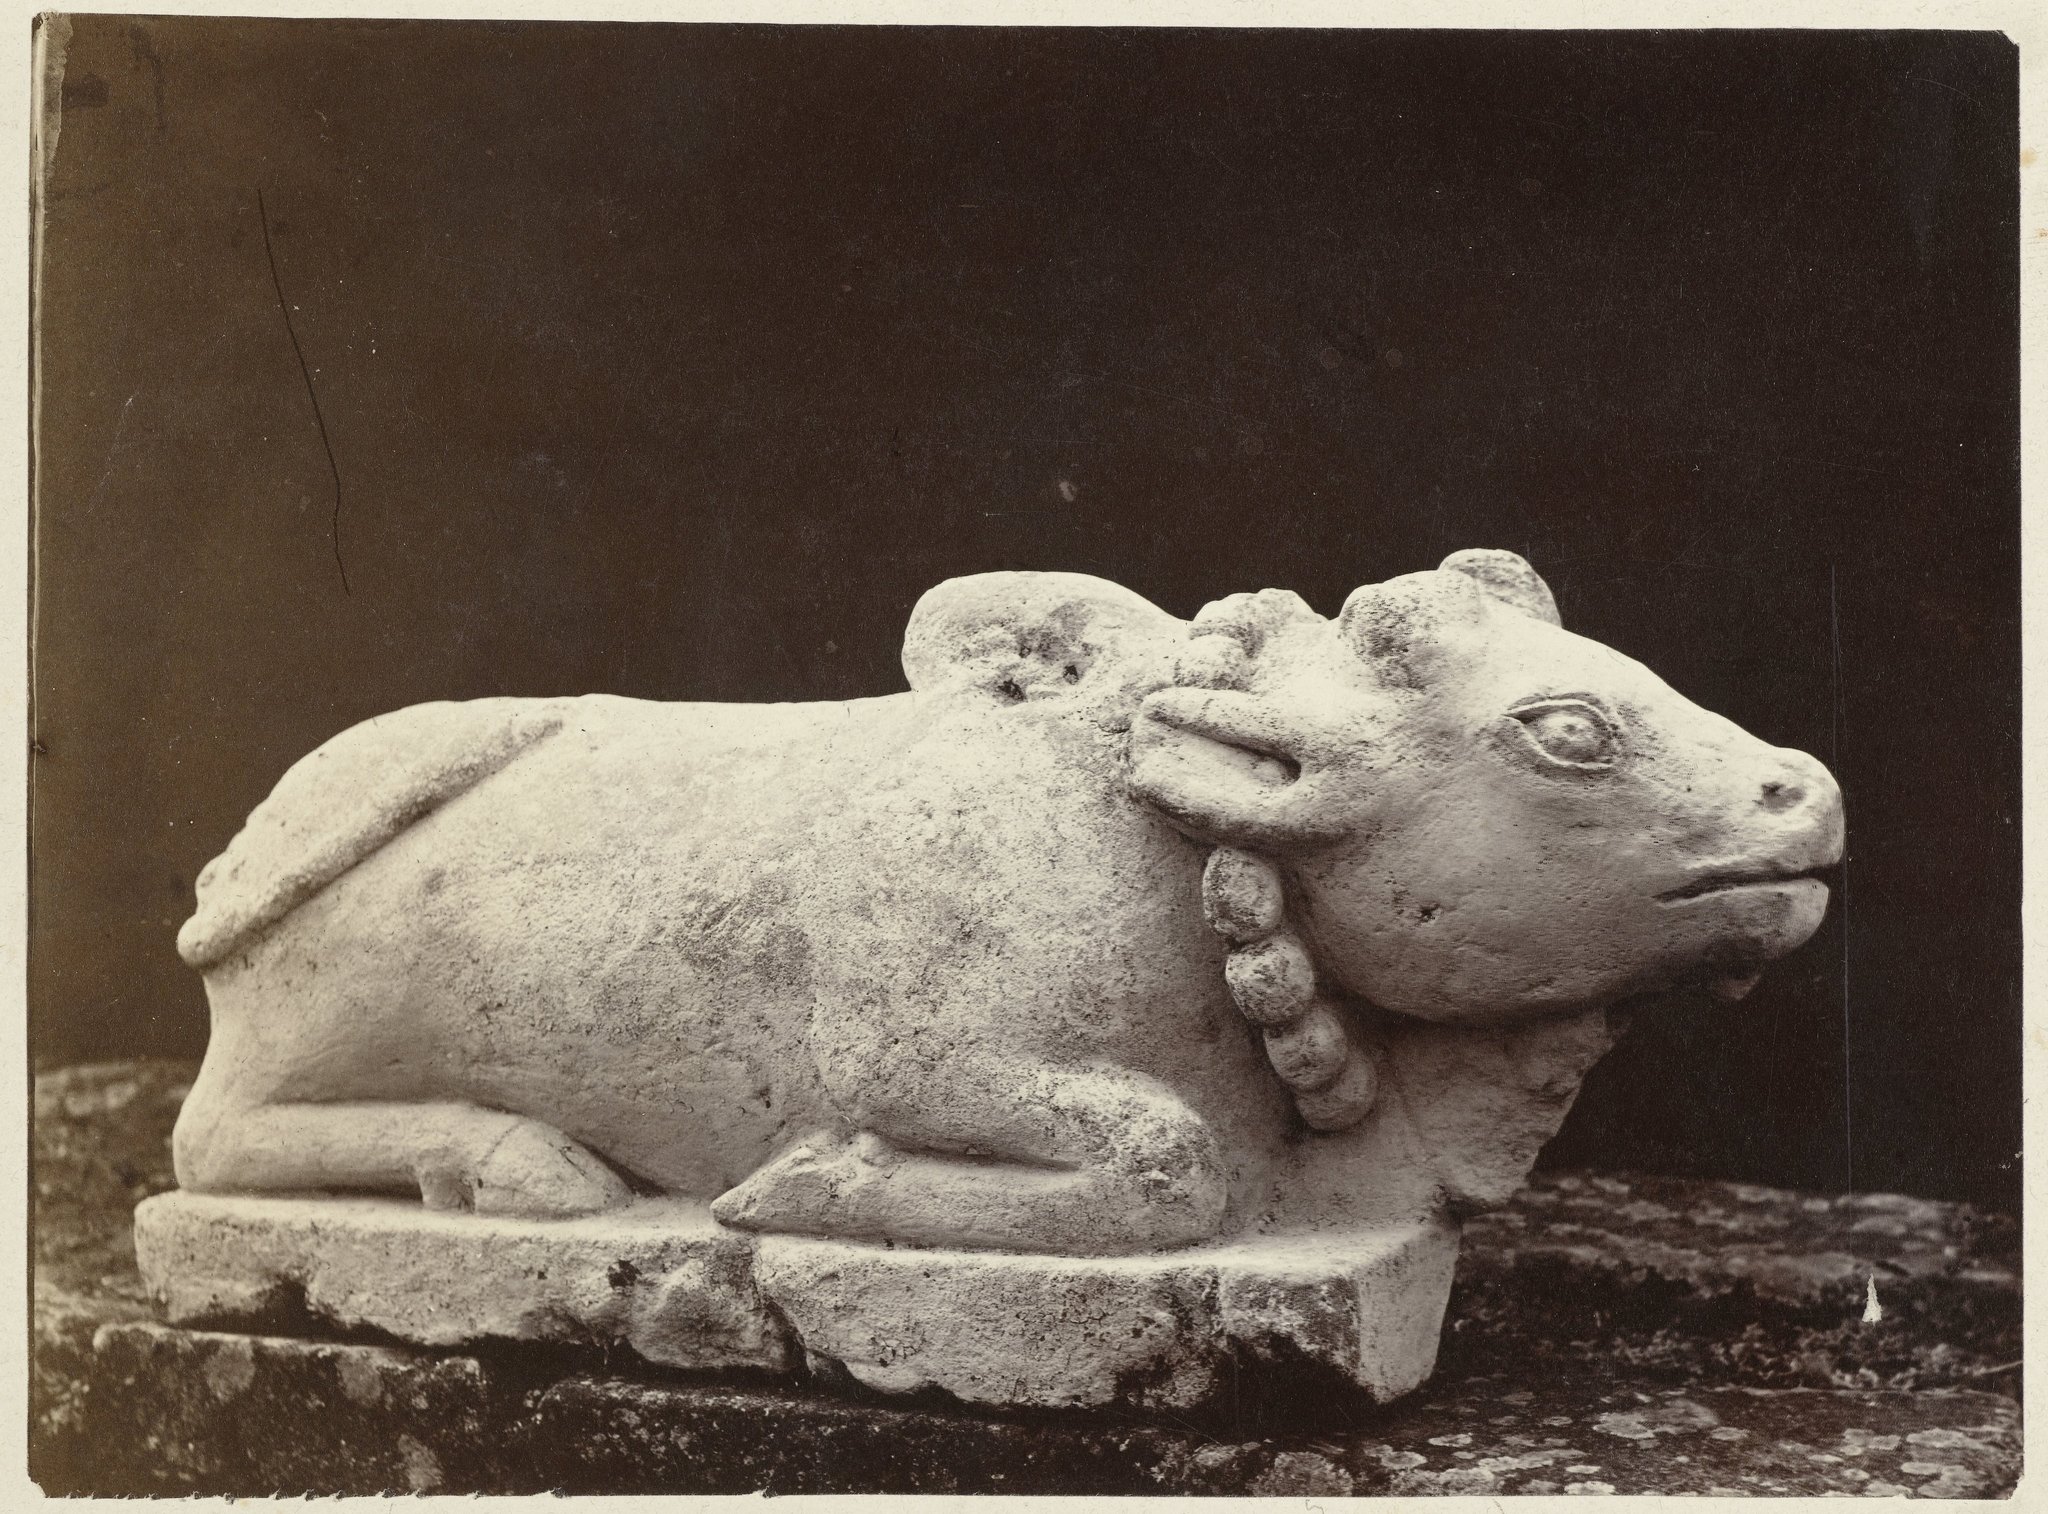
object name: photograph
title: Nandi, the vehicle of Shiva. Dieng Plateau , Wonosobo district , Central Java province , 8th - 9th century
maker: isidore kinsbergen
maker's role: fotograaf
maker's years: 1821-1905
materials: cardboard, paper, photographic support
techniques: albumen print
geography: java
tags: nandi (bull)